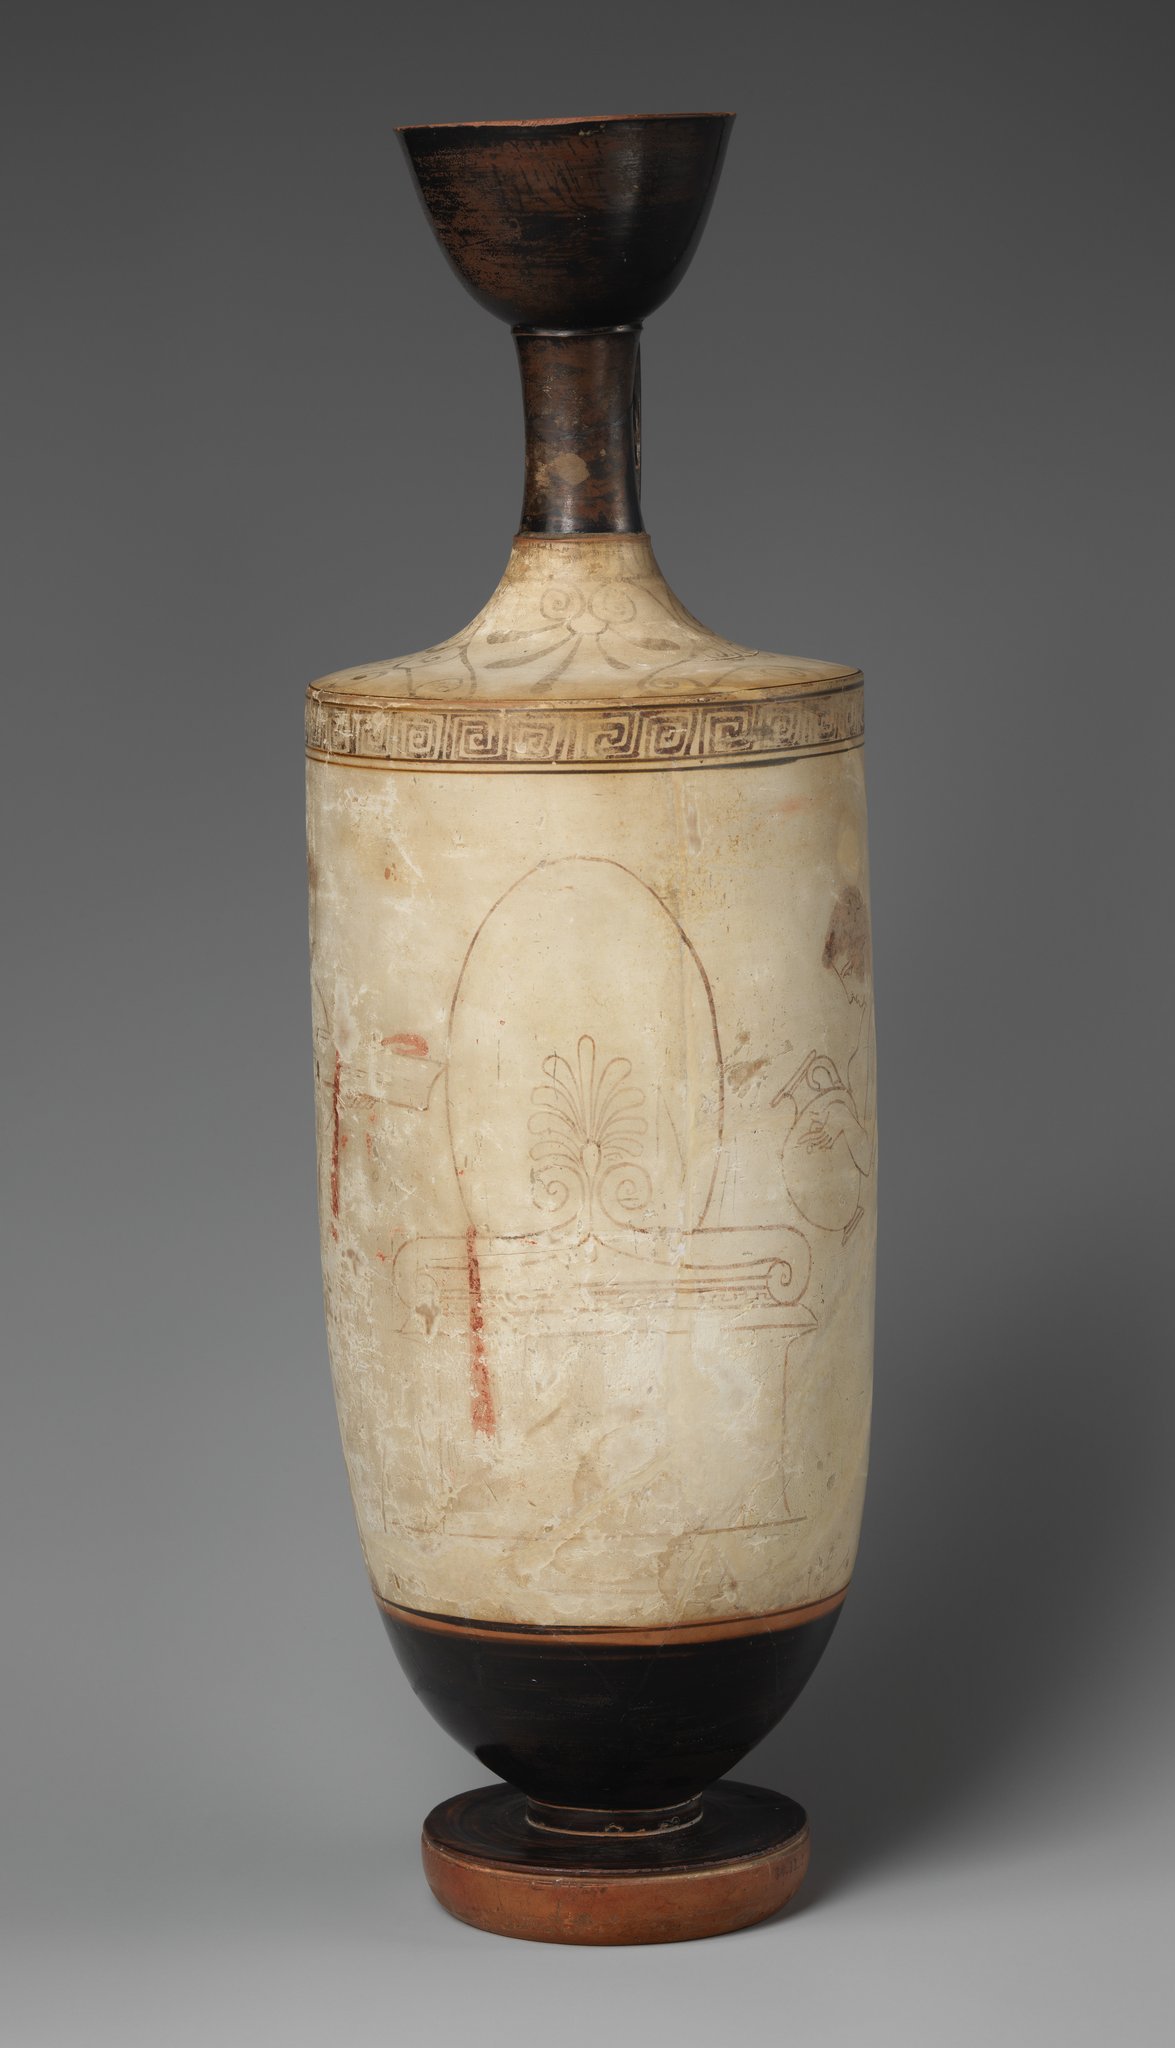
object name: lekythos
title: Terracotta lekythos (oil flask)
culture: greek, attic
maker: painter of munich 2335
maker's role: artist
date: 440 BCE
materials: terracotta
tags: tombs,women